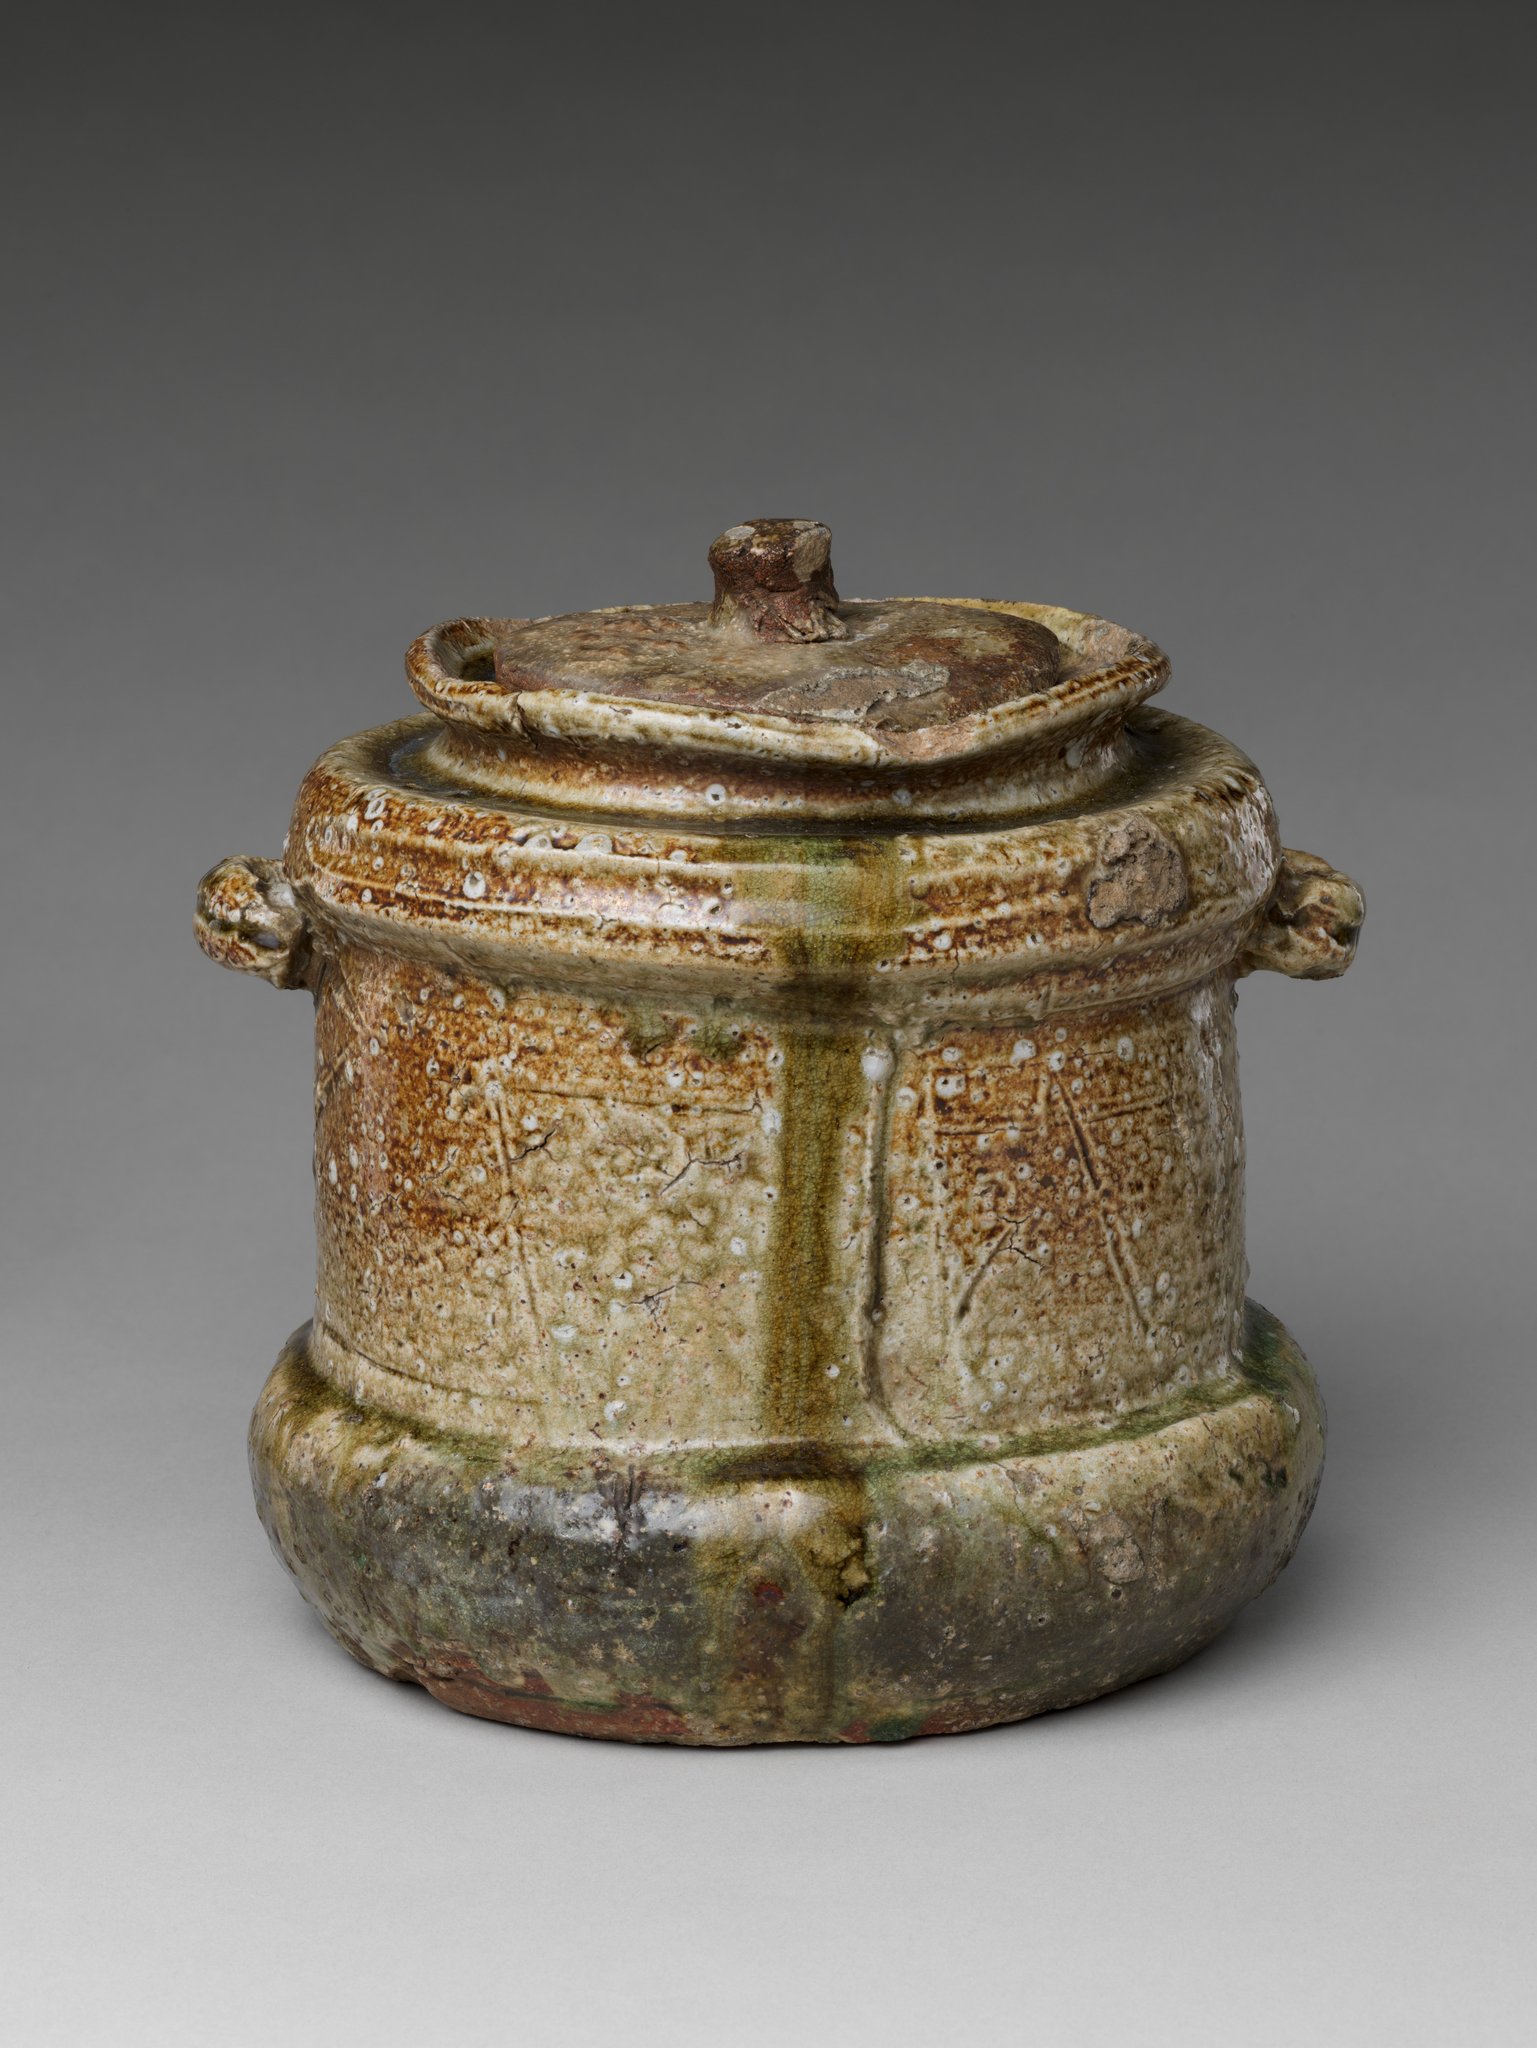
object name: freshwater jar mizusashi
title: Freshwater Jar (Mizusashi), titled Hotei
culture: japanese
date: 1600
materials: wood, glaze, stoneware